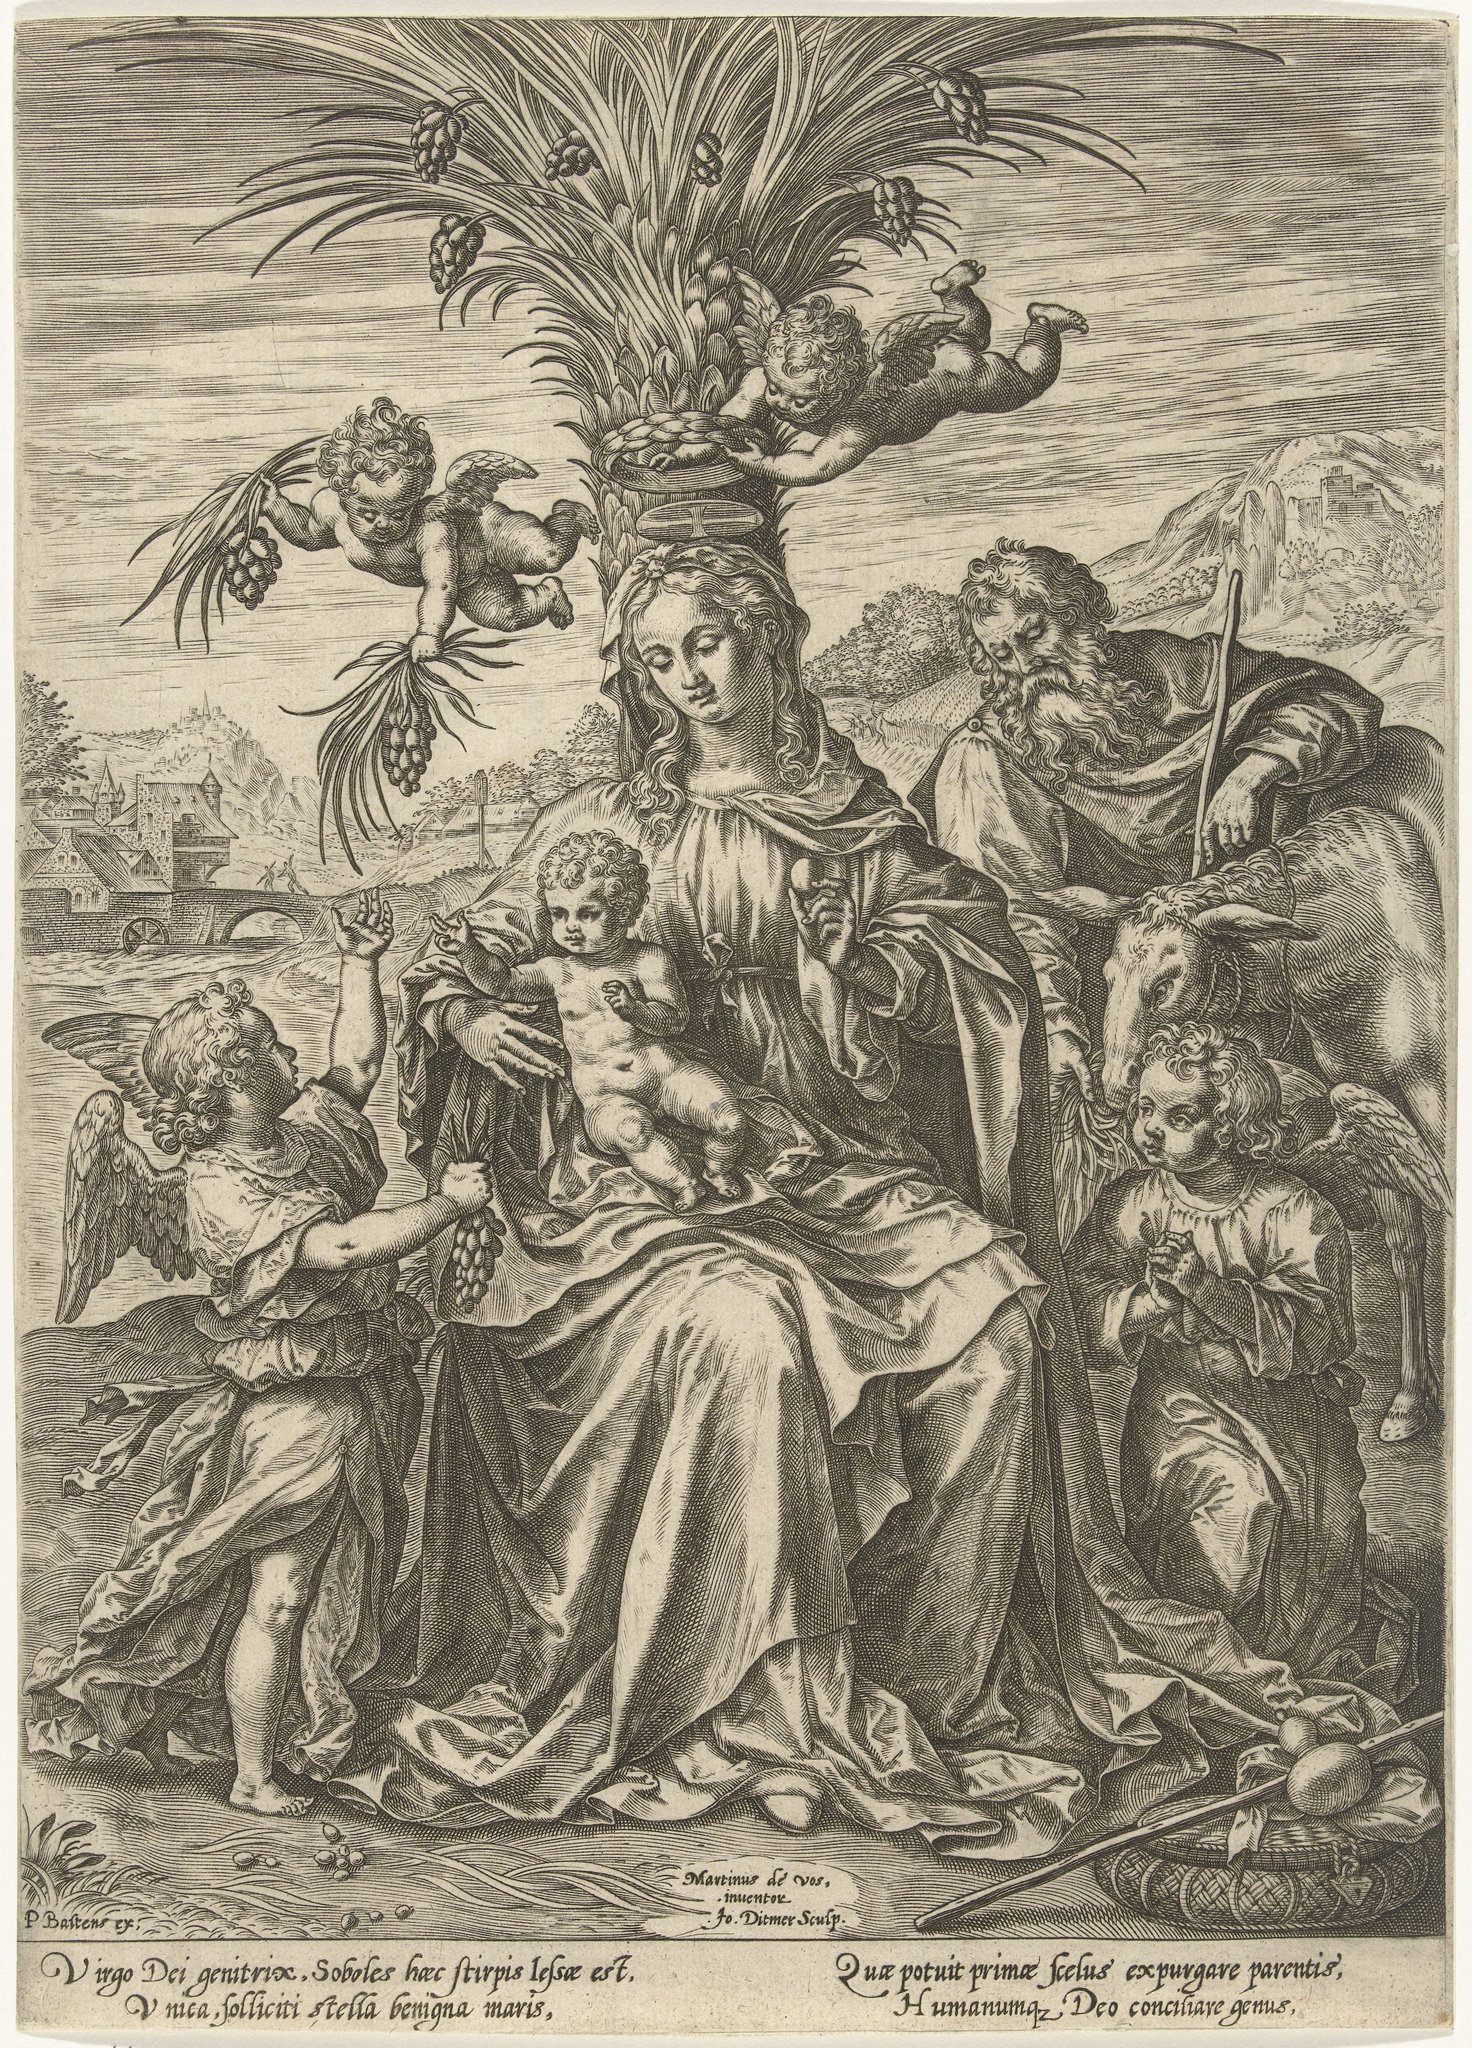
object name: print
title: Rest on the Flight into Egypt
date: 1548-1603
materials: paper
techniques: engraving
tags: the flight into egypt: mary, joseph, the child (and sometimes others) on their way; mary usually riding on an ass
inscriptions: collector's mark: Lugt 2228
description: Heilige familie rustend op de vlucht naar Egypte. Maria met kind zittend bij palmboom met engelen. Jozef met ezel op de achtergrond. In ondermarge vier regels Latijnse tekst.